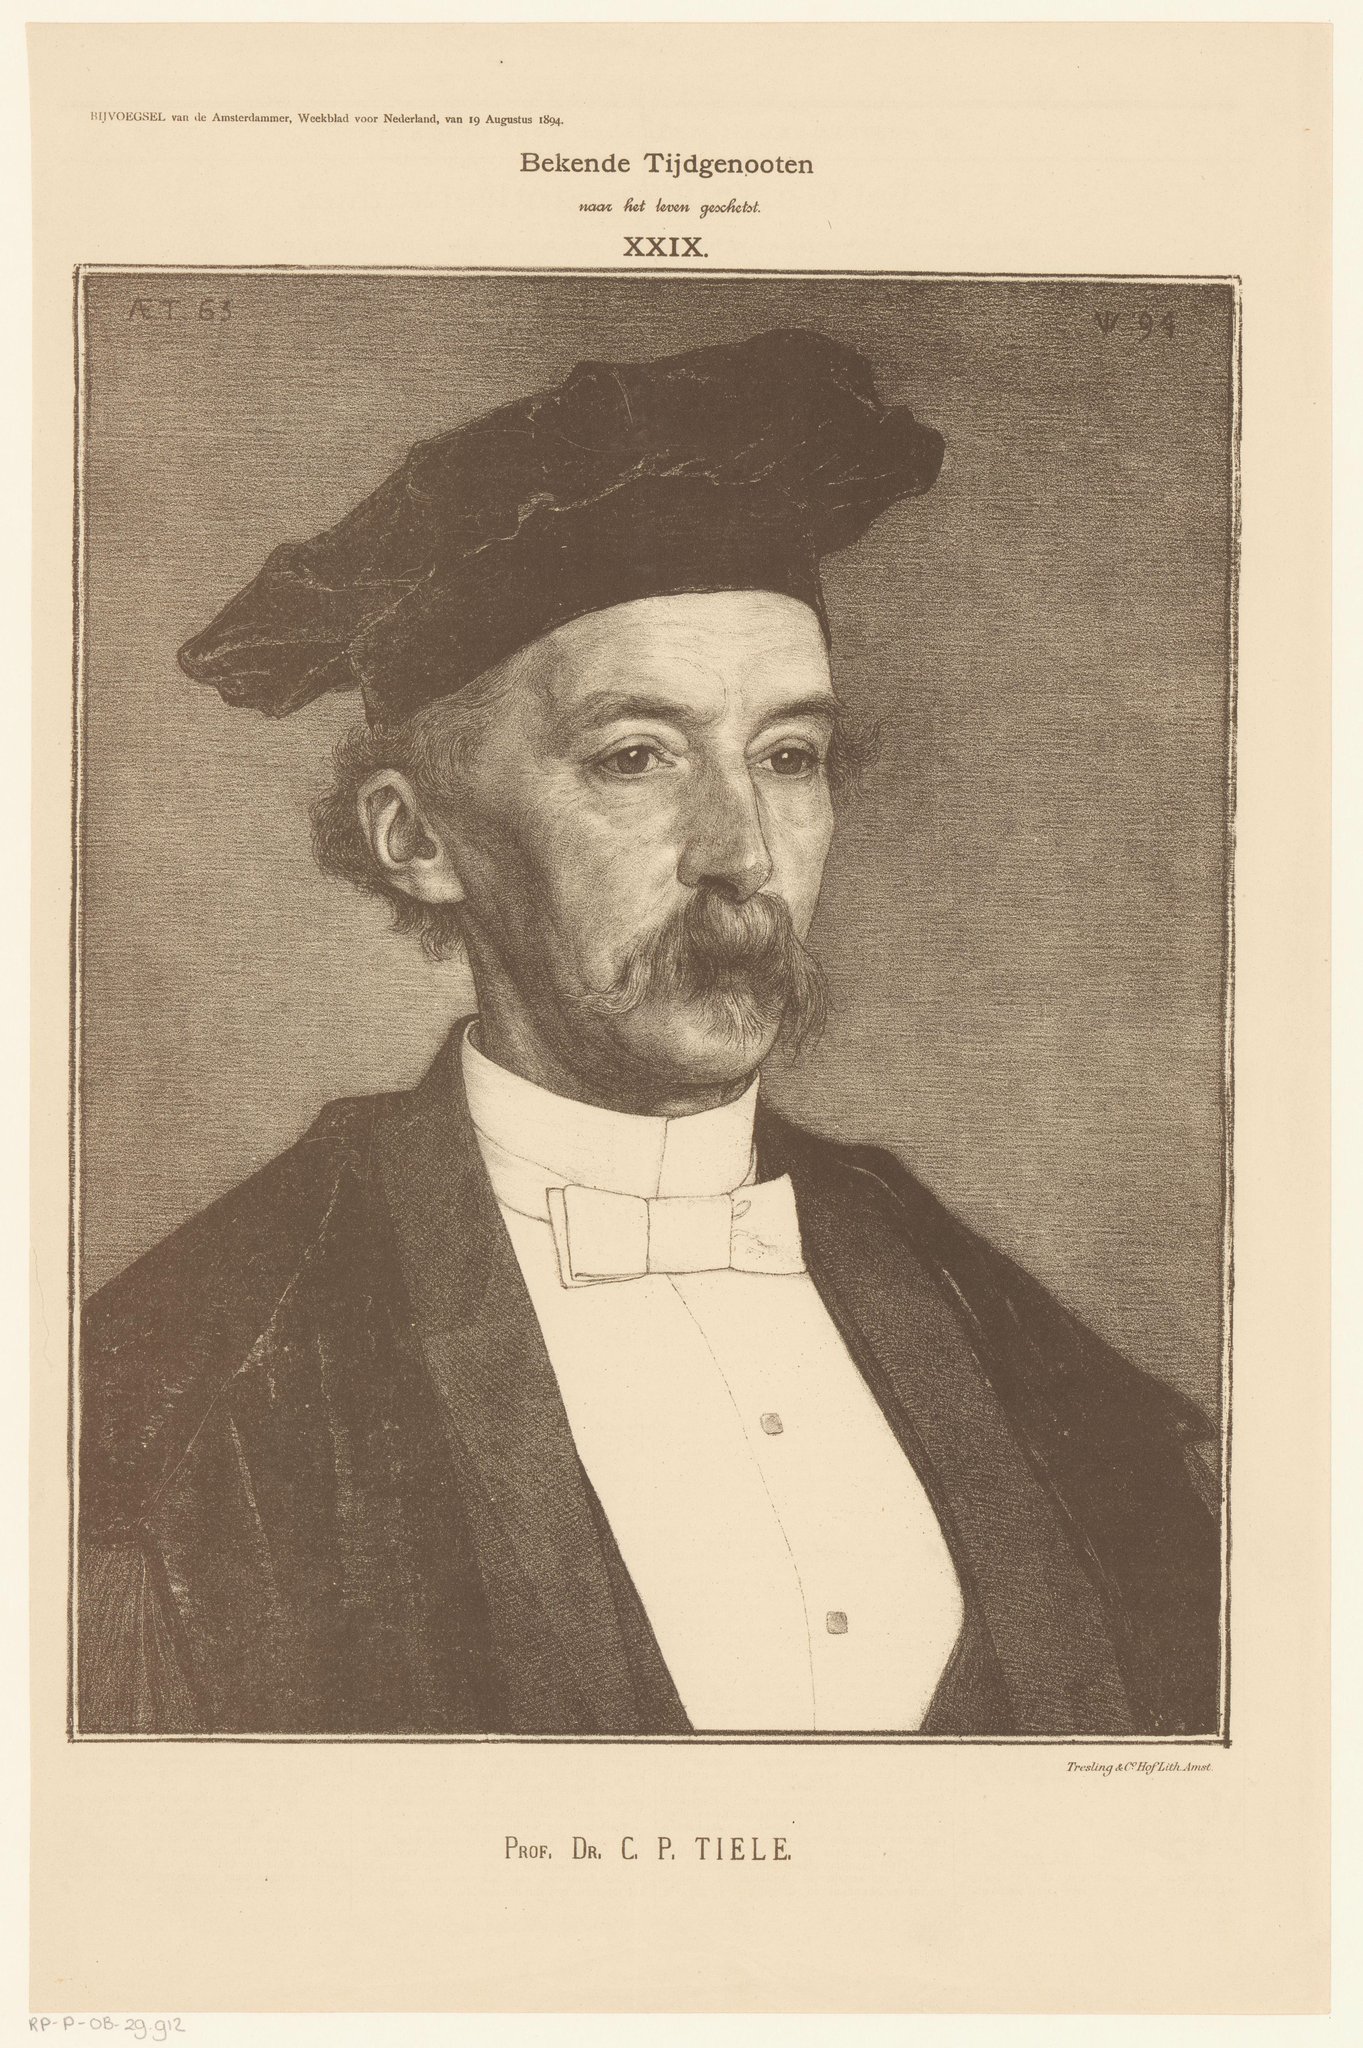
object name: print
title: Prof. Dr. C.P. Tiele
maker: jan veth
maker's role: designer, draughtsman, painter, print maker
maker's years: 1864-1925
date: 1894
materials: paper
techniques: lithograph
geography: amsterdam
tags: leiden, cornelis petrus tiele, historical persons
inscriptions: collector's mark: Lugt 2228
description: Deze prent werd uitgegeven als bijvoegsel van De Amsterdammer op 19 augustus 1894.